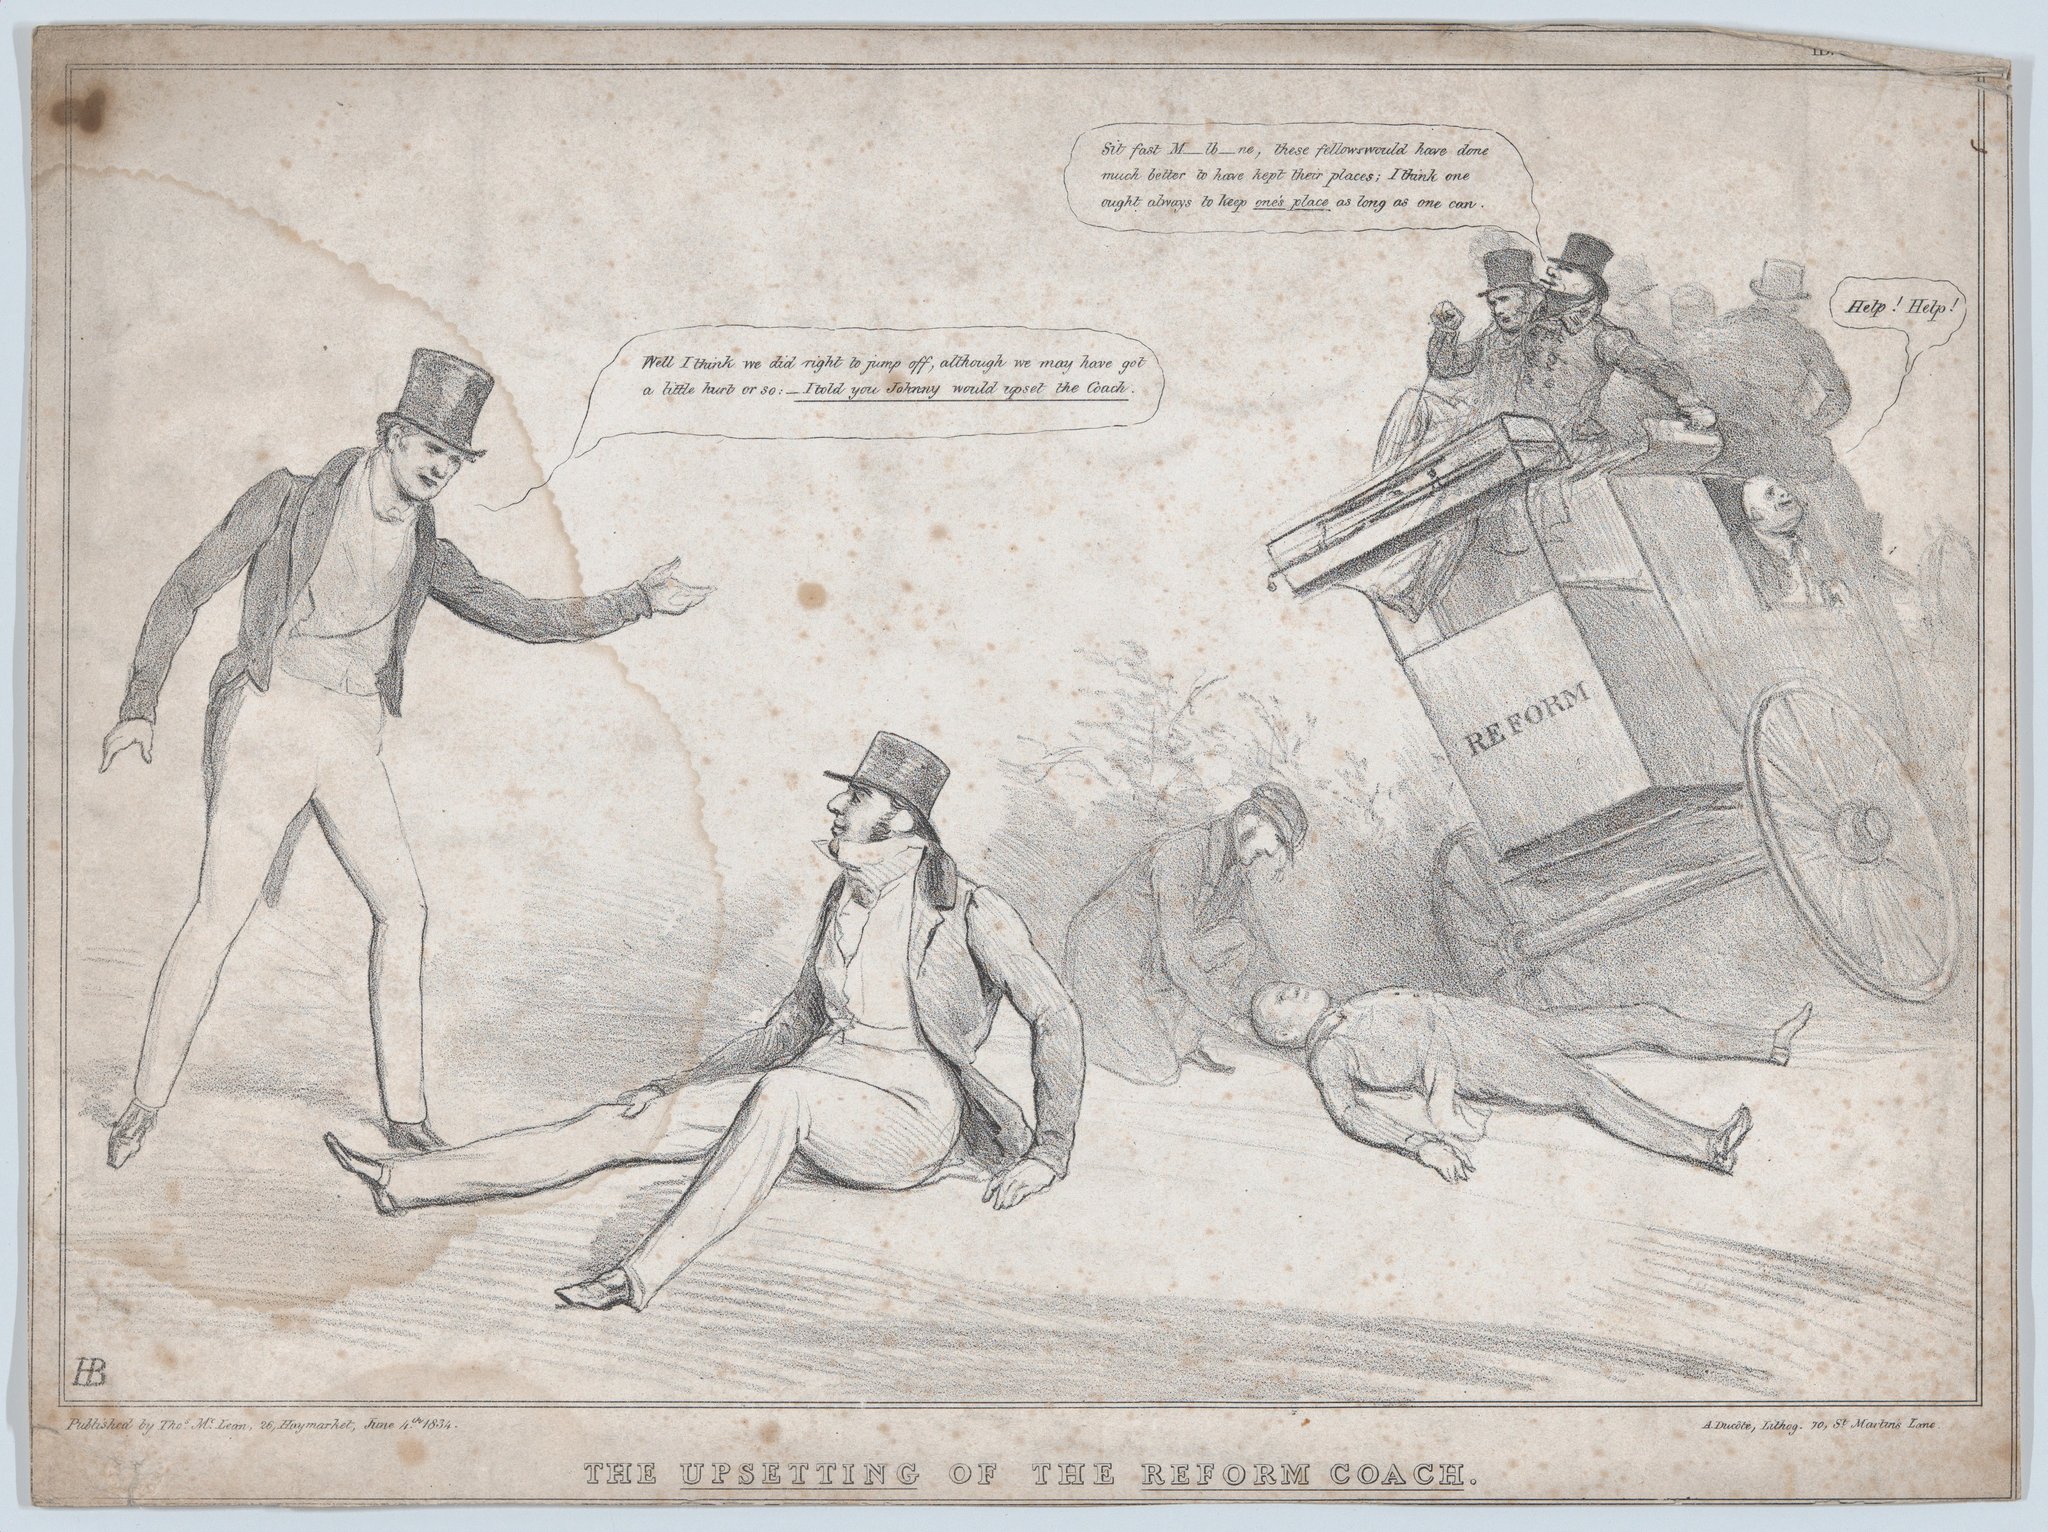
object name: print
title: The Upsetting of the Reform Coach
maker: john doyle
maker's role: artist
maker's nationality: irish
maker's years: 1797-1868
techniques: lithograph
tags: men,carriages